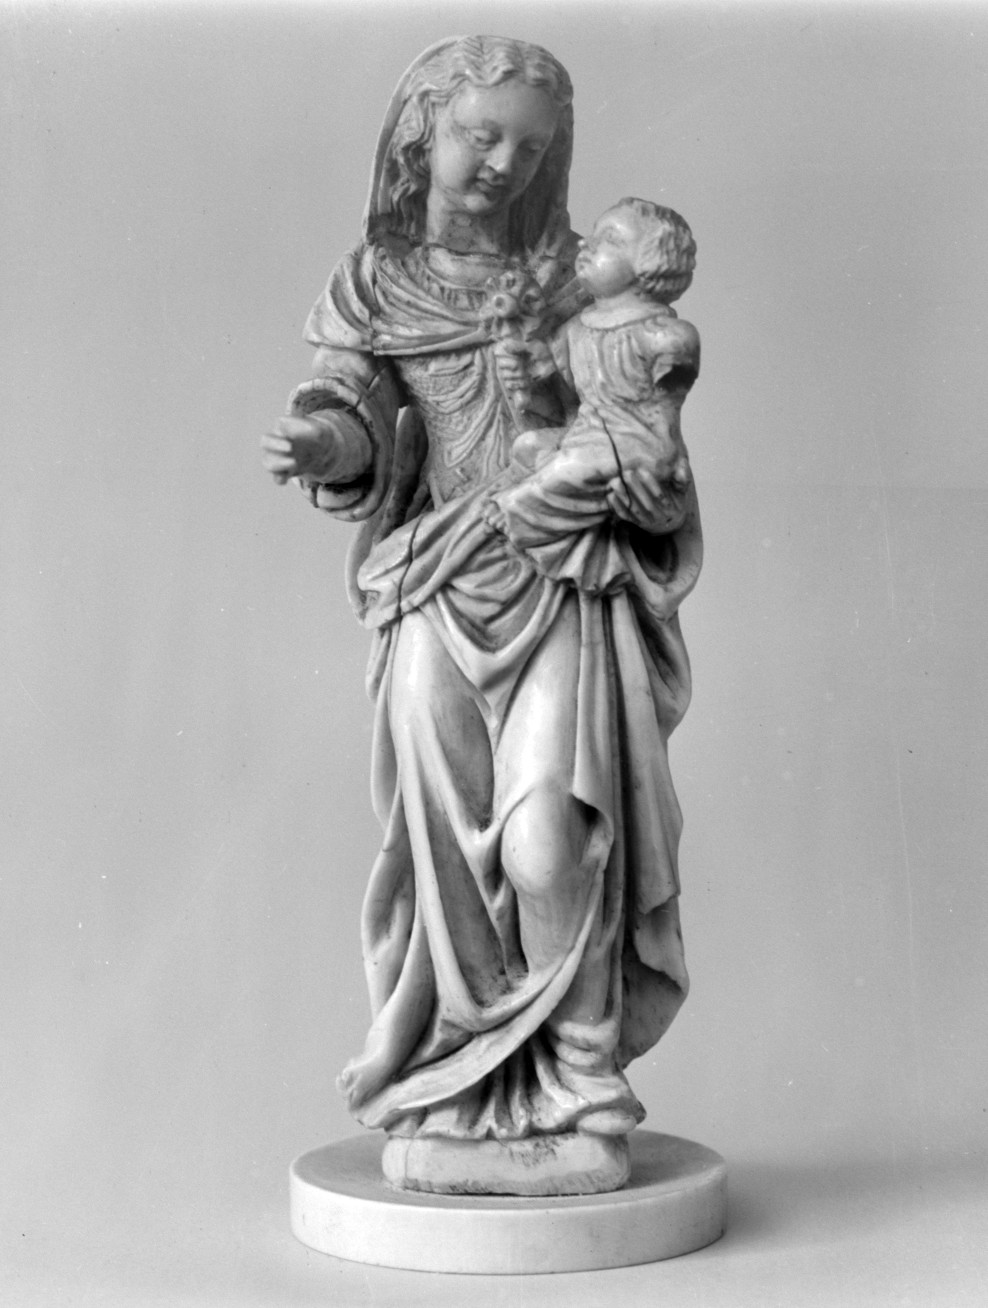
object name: statuette group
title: Madonna and Child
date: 1567-1600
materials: ivory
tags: madonna and child